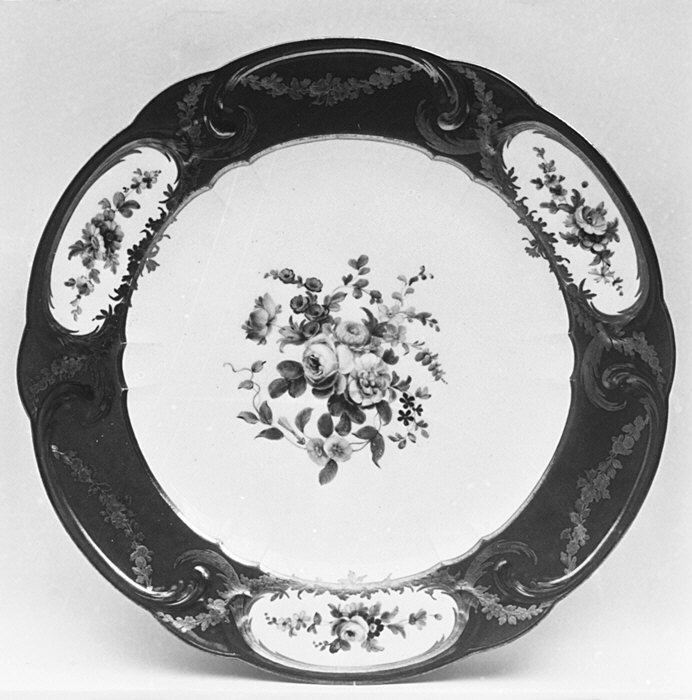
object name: plate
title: Plate (assiette à palmes) (1 of 102) (part of a service)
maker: sèvres manufactory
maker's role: manufactory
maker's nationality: french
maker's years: 1740-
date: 1780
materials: soft paste porcelain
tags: flowers